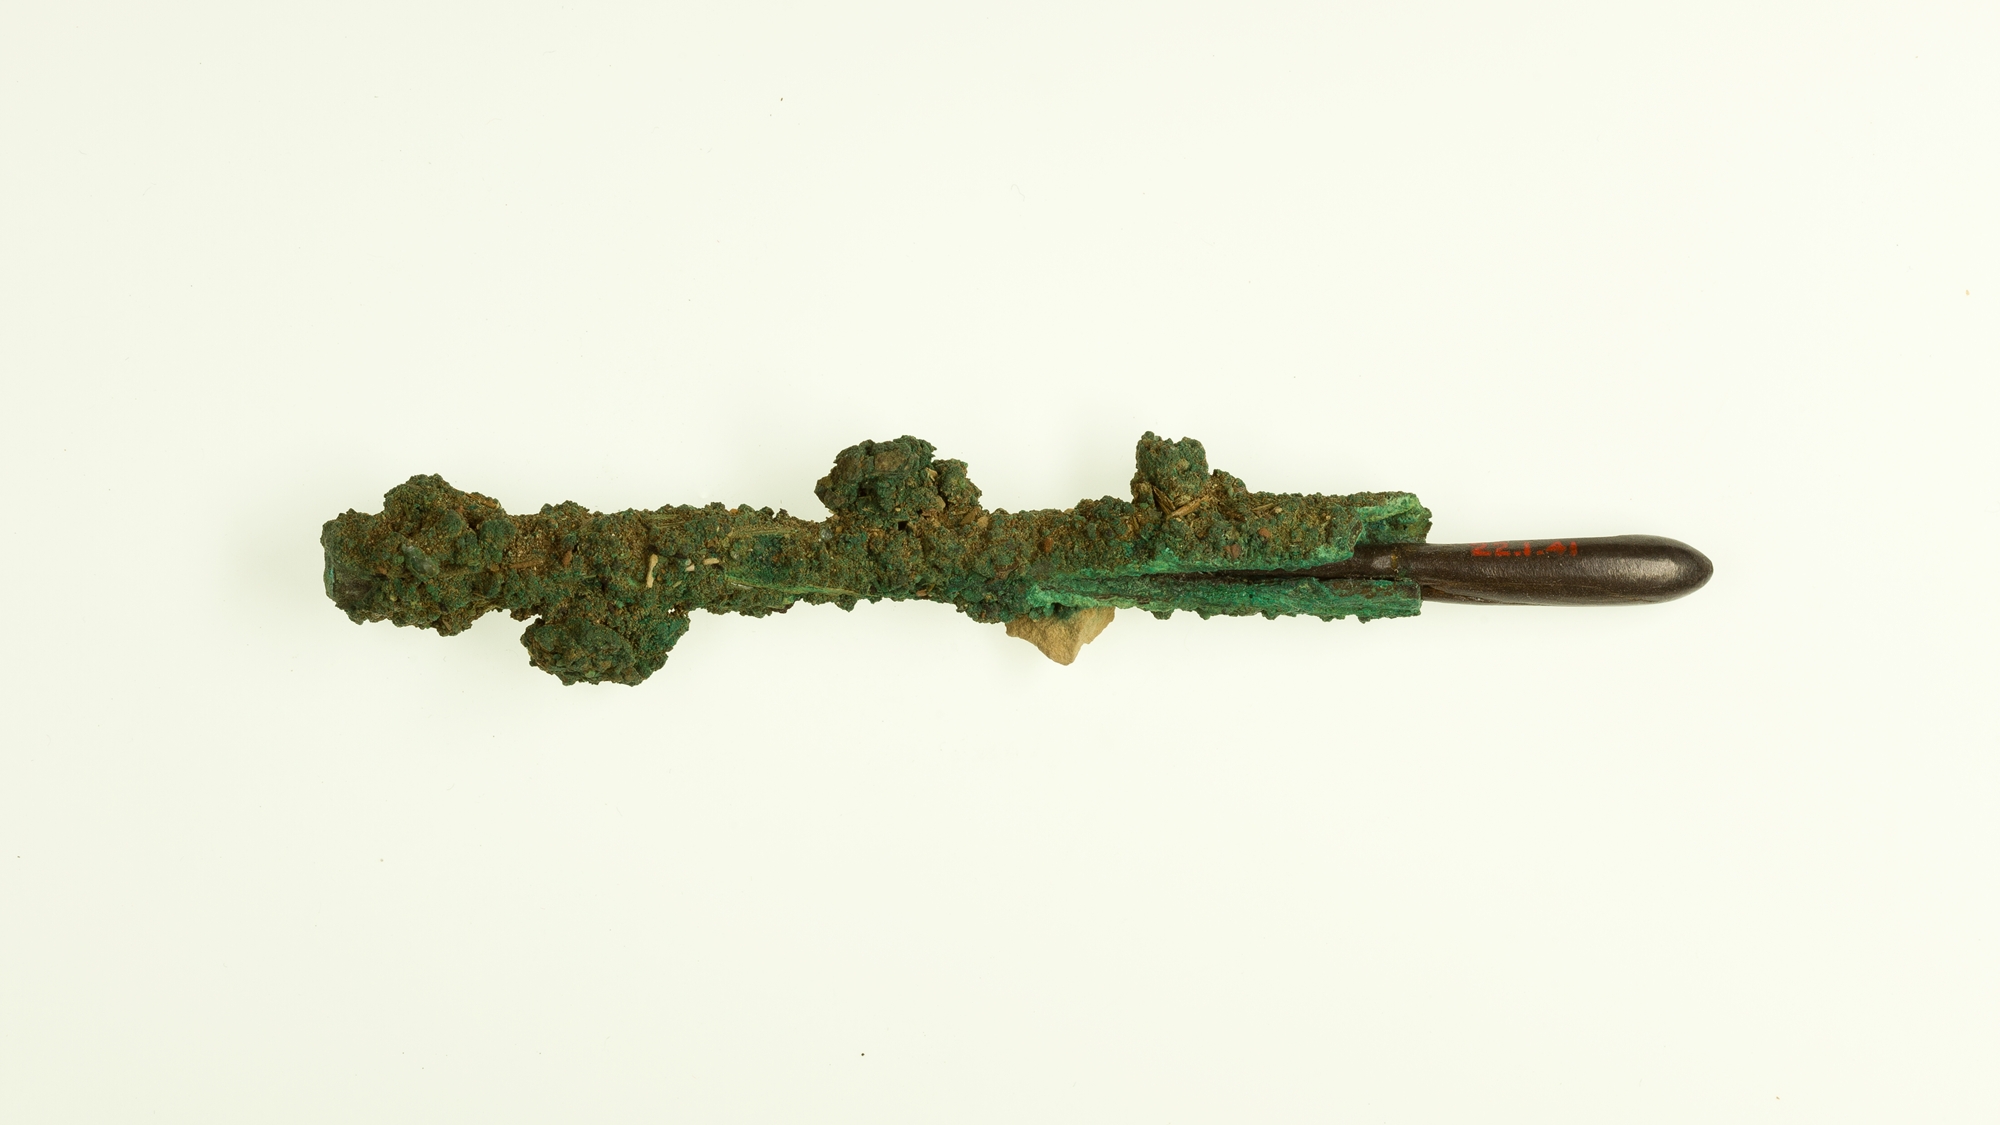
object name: kohl stick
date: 1295-1070 BCE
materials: bronze, mineral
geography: egypt